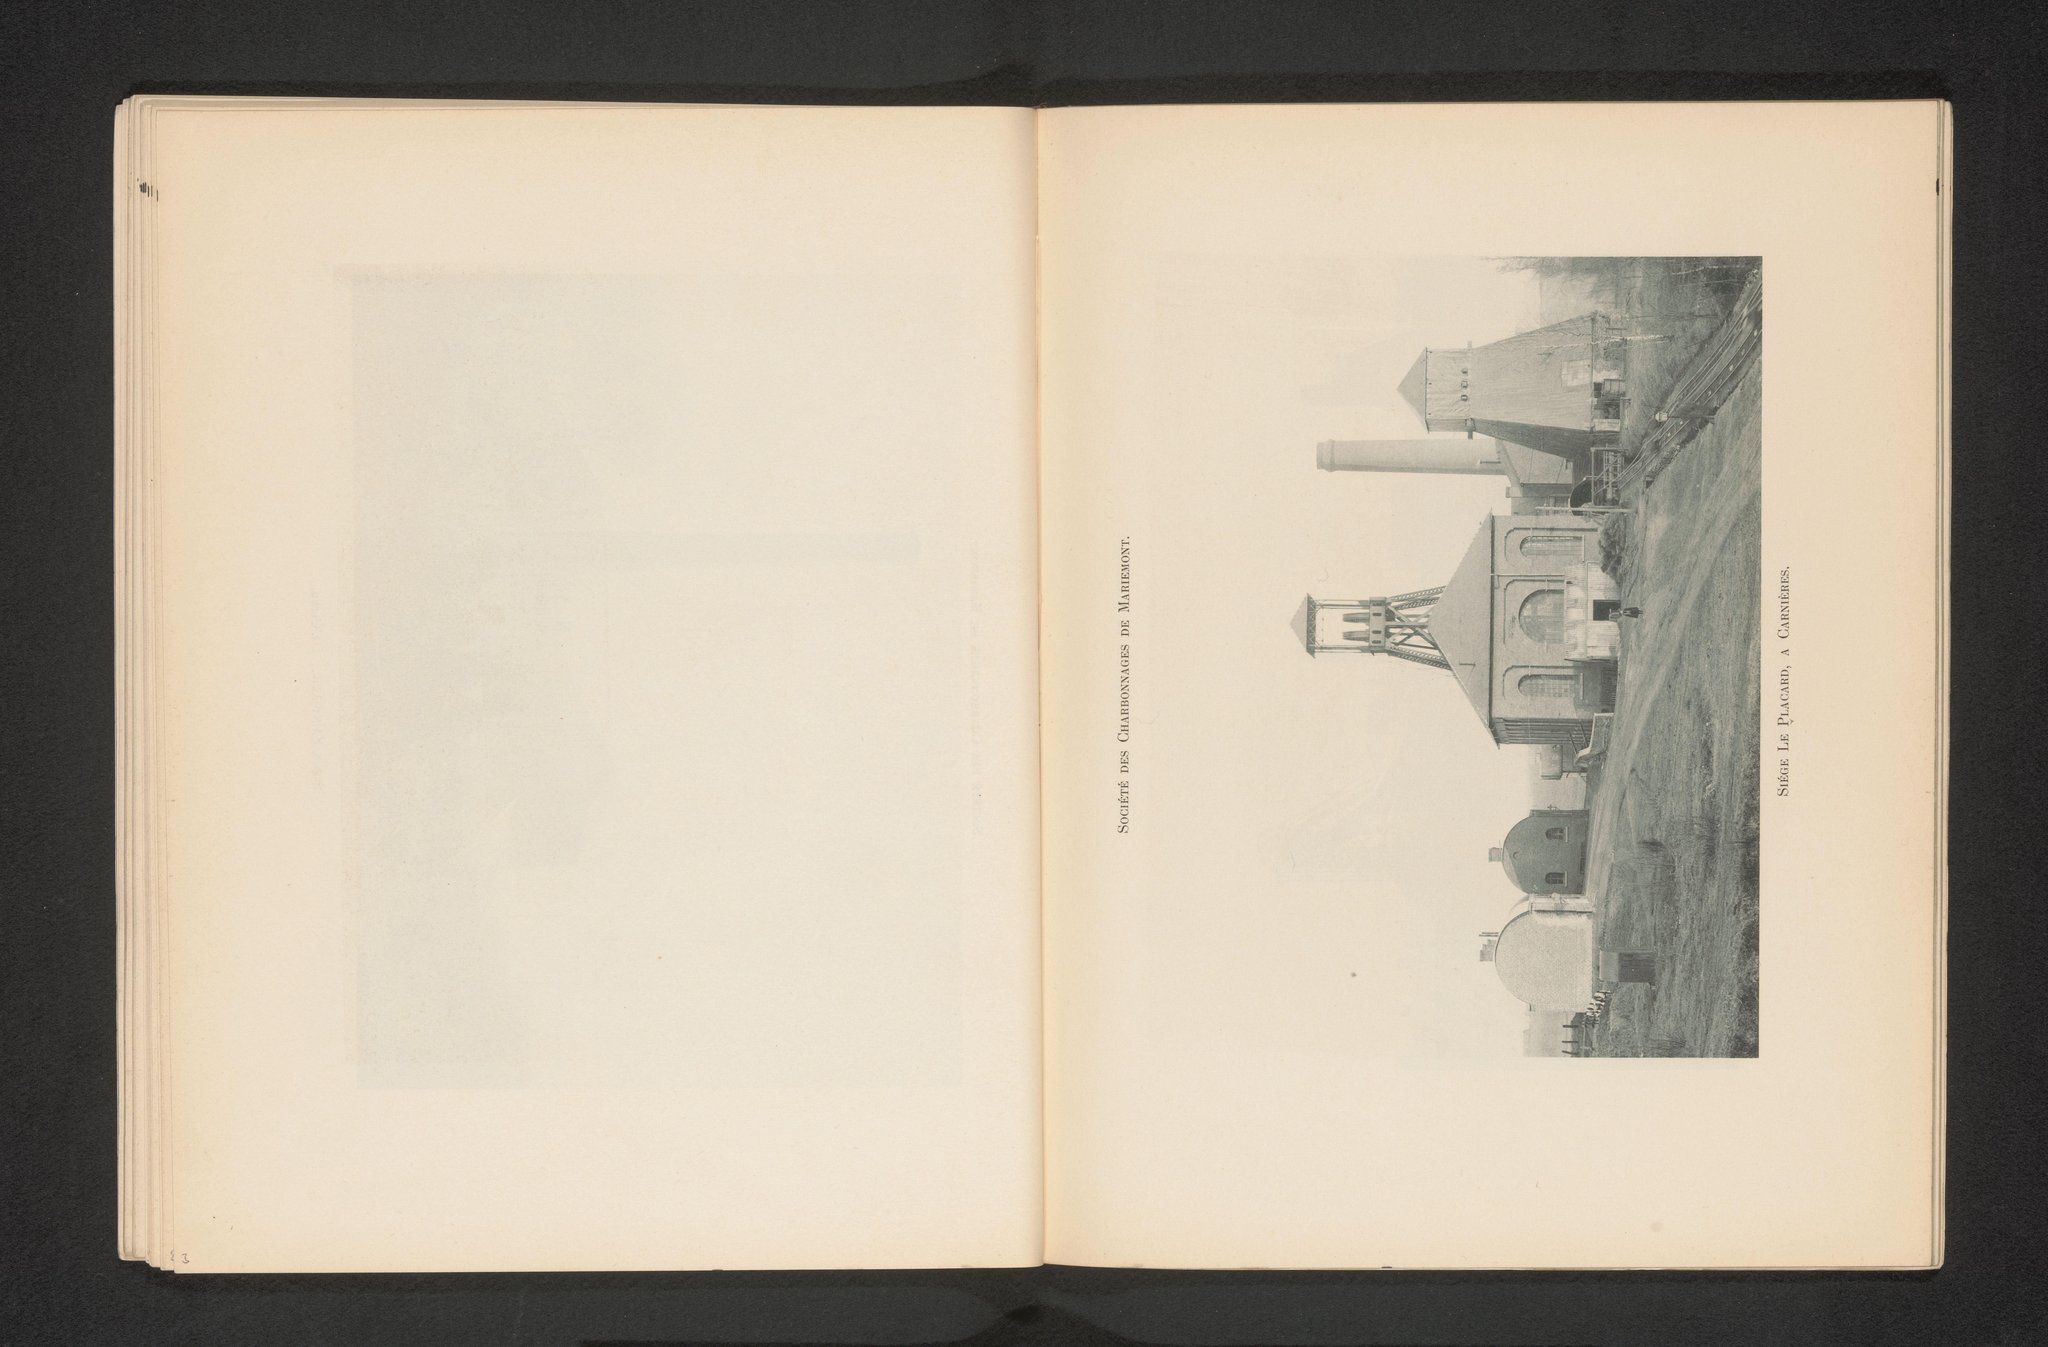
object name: photomechanical print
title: Gezicht op de steenkolenmijn van Le Placard te Carnières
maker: Anonymous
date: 1895-1900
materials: paper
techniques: photograph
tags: mine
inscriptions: inscription: ‘Société des Charbonnages de Mariemont’